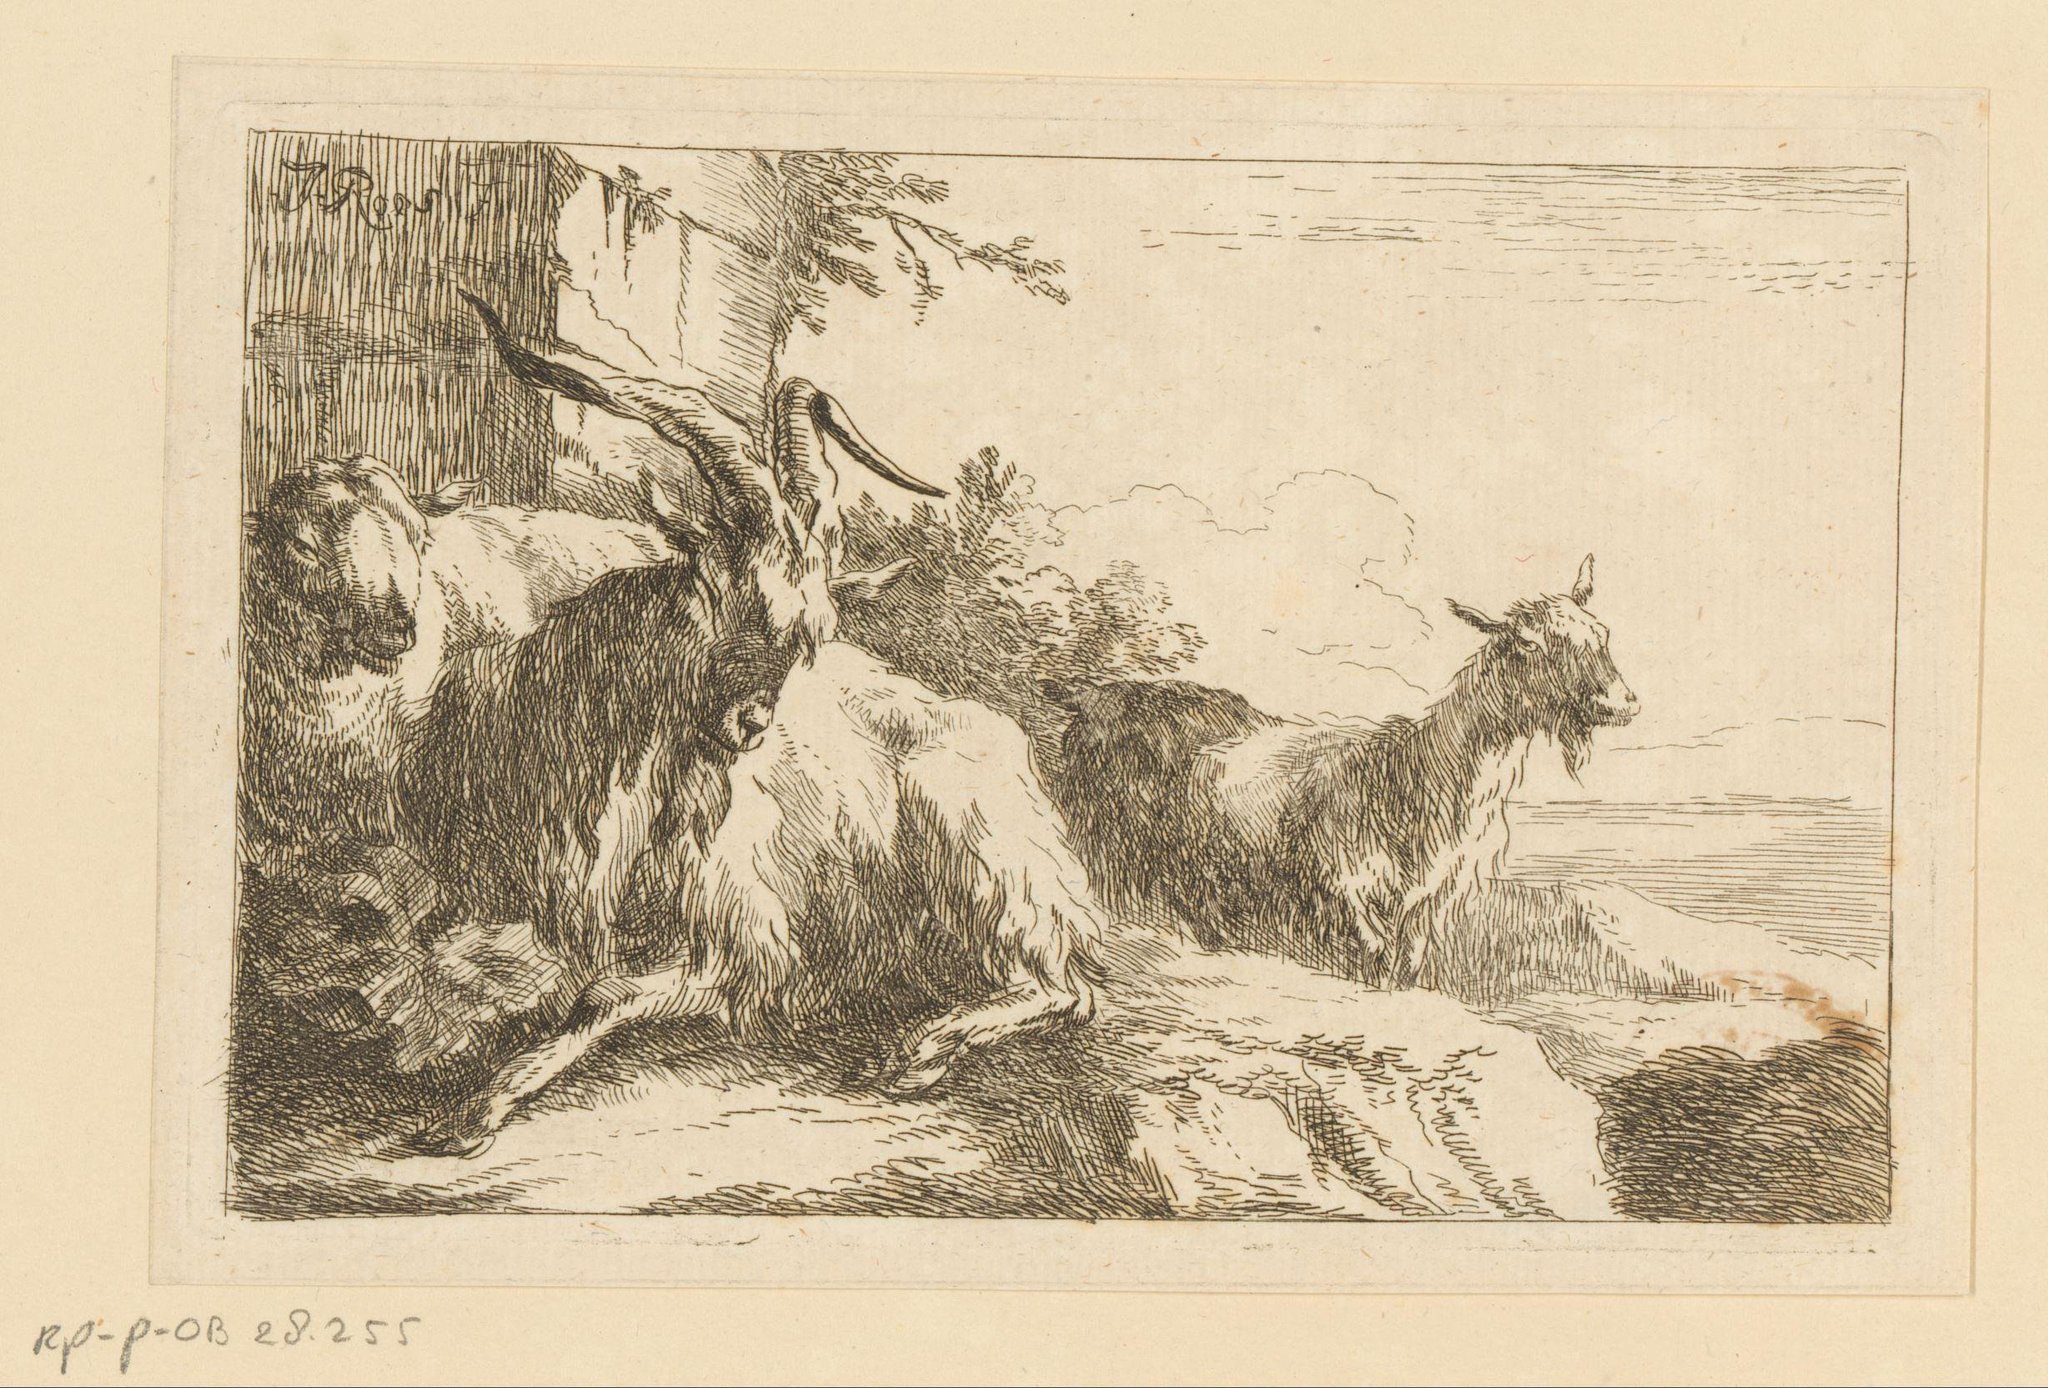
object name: print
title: Twee geiten en een schaap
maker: joseph roos (i)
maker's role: print maker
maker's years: 1726-1805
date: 1754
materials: paper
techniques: etching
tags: landscapes, sheep, goat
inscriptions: collector's mark: Lugt 240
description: Serie van twaalf prenten, waarvan één titelprent.